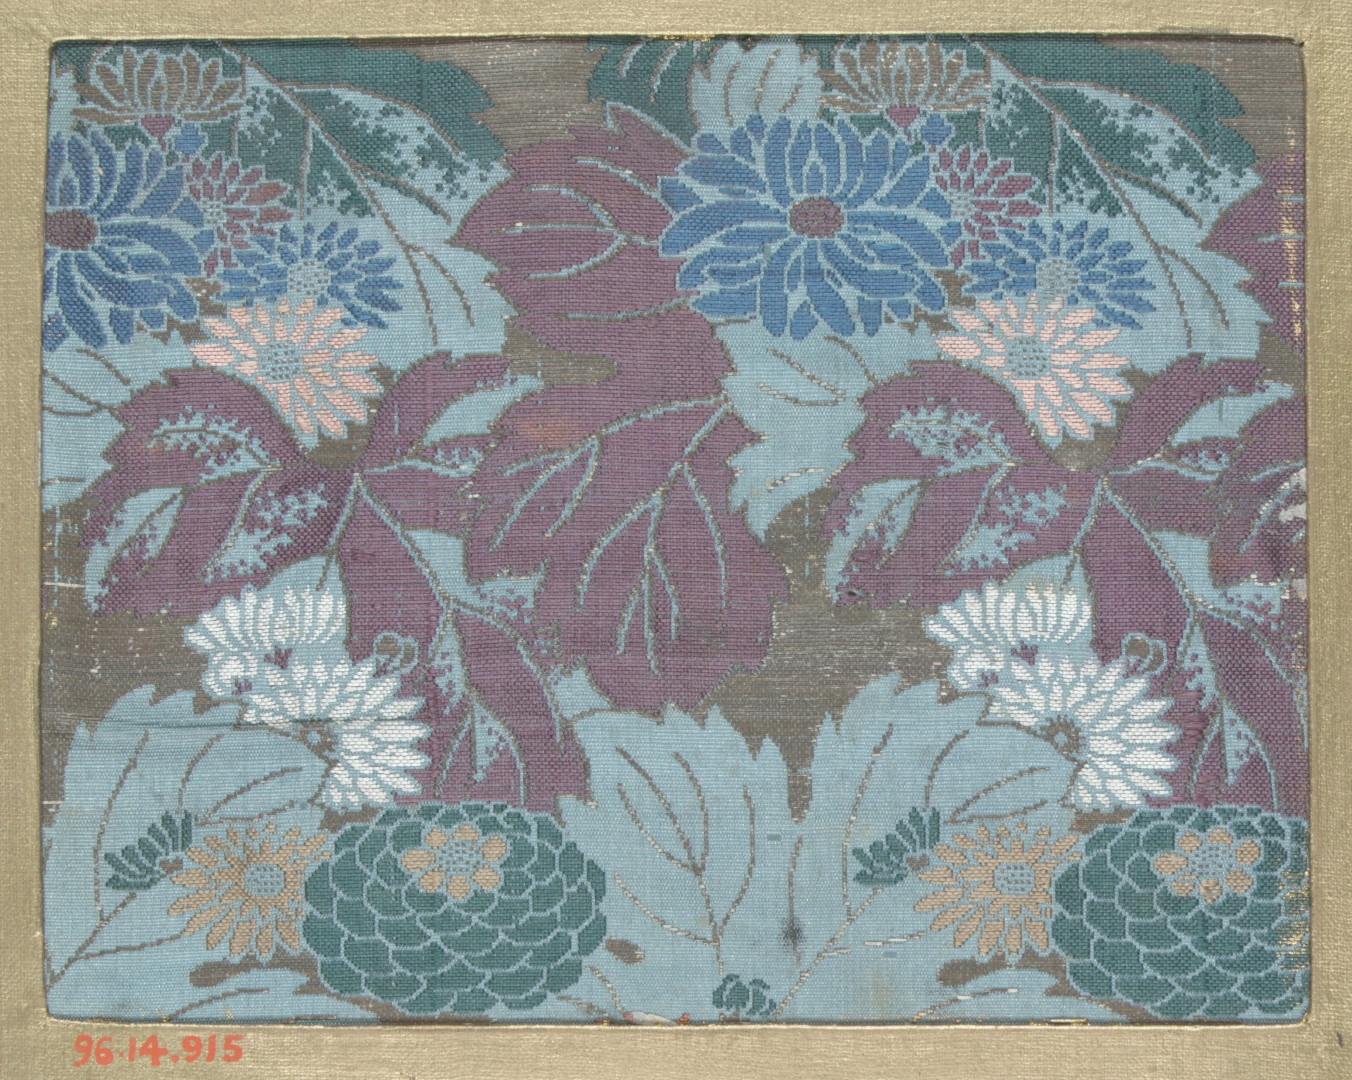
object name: piece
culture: japanese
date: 1701-1900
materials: silk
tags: leaves